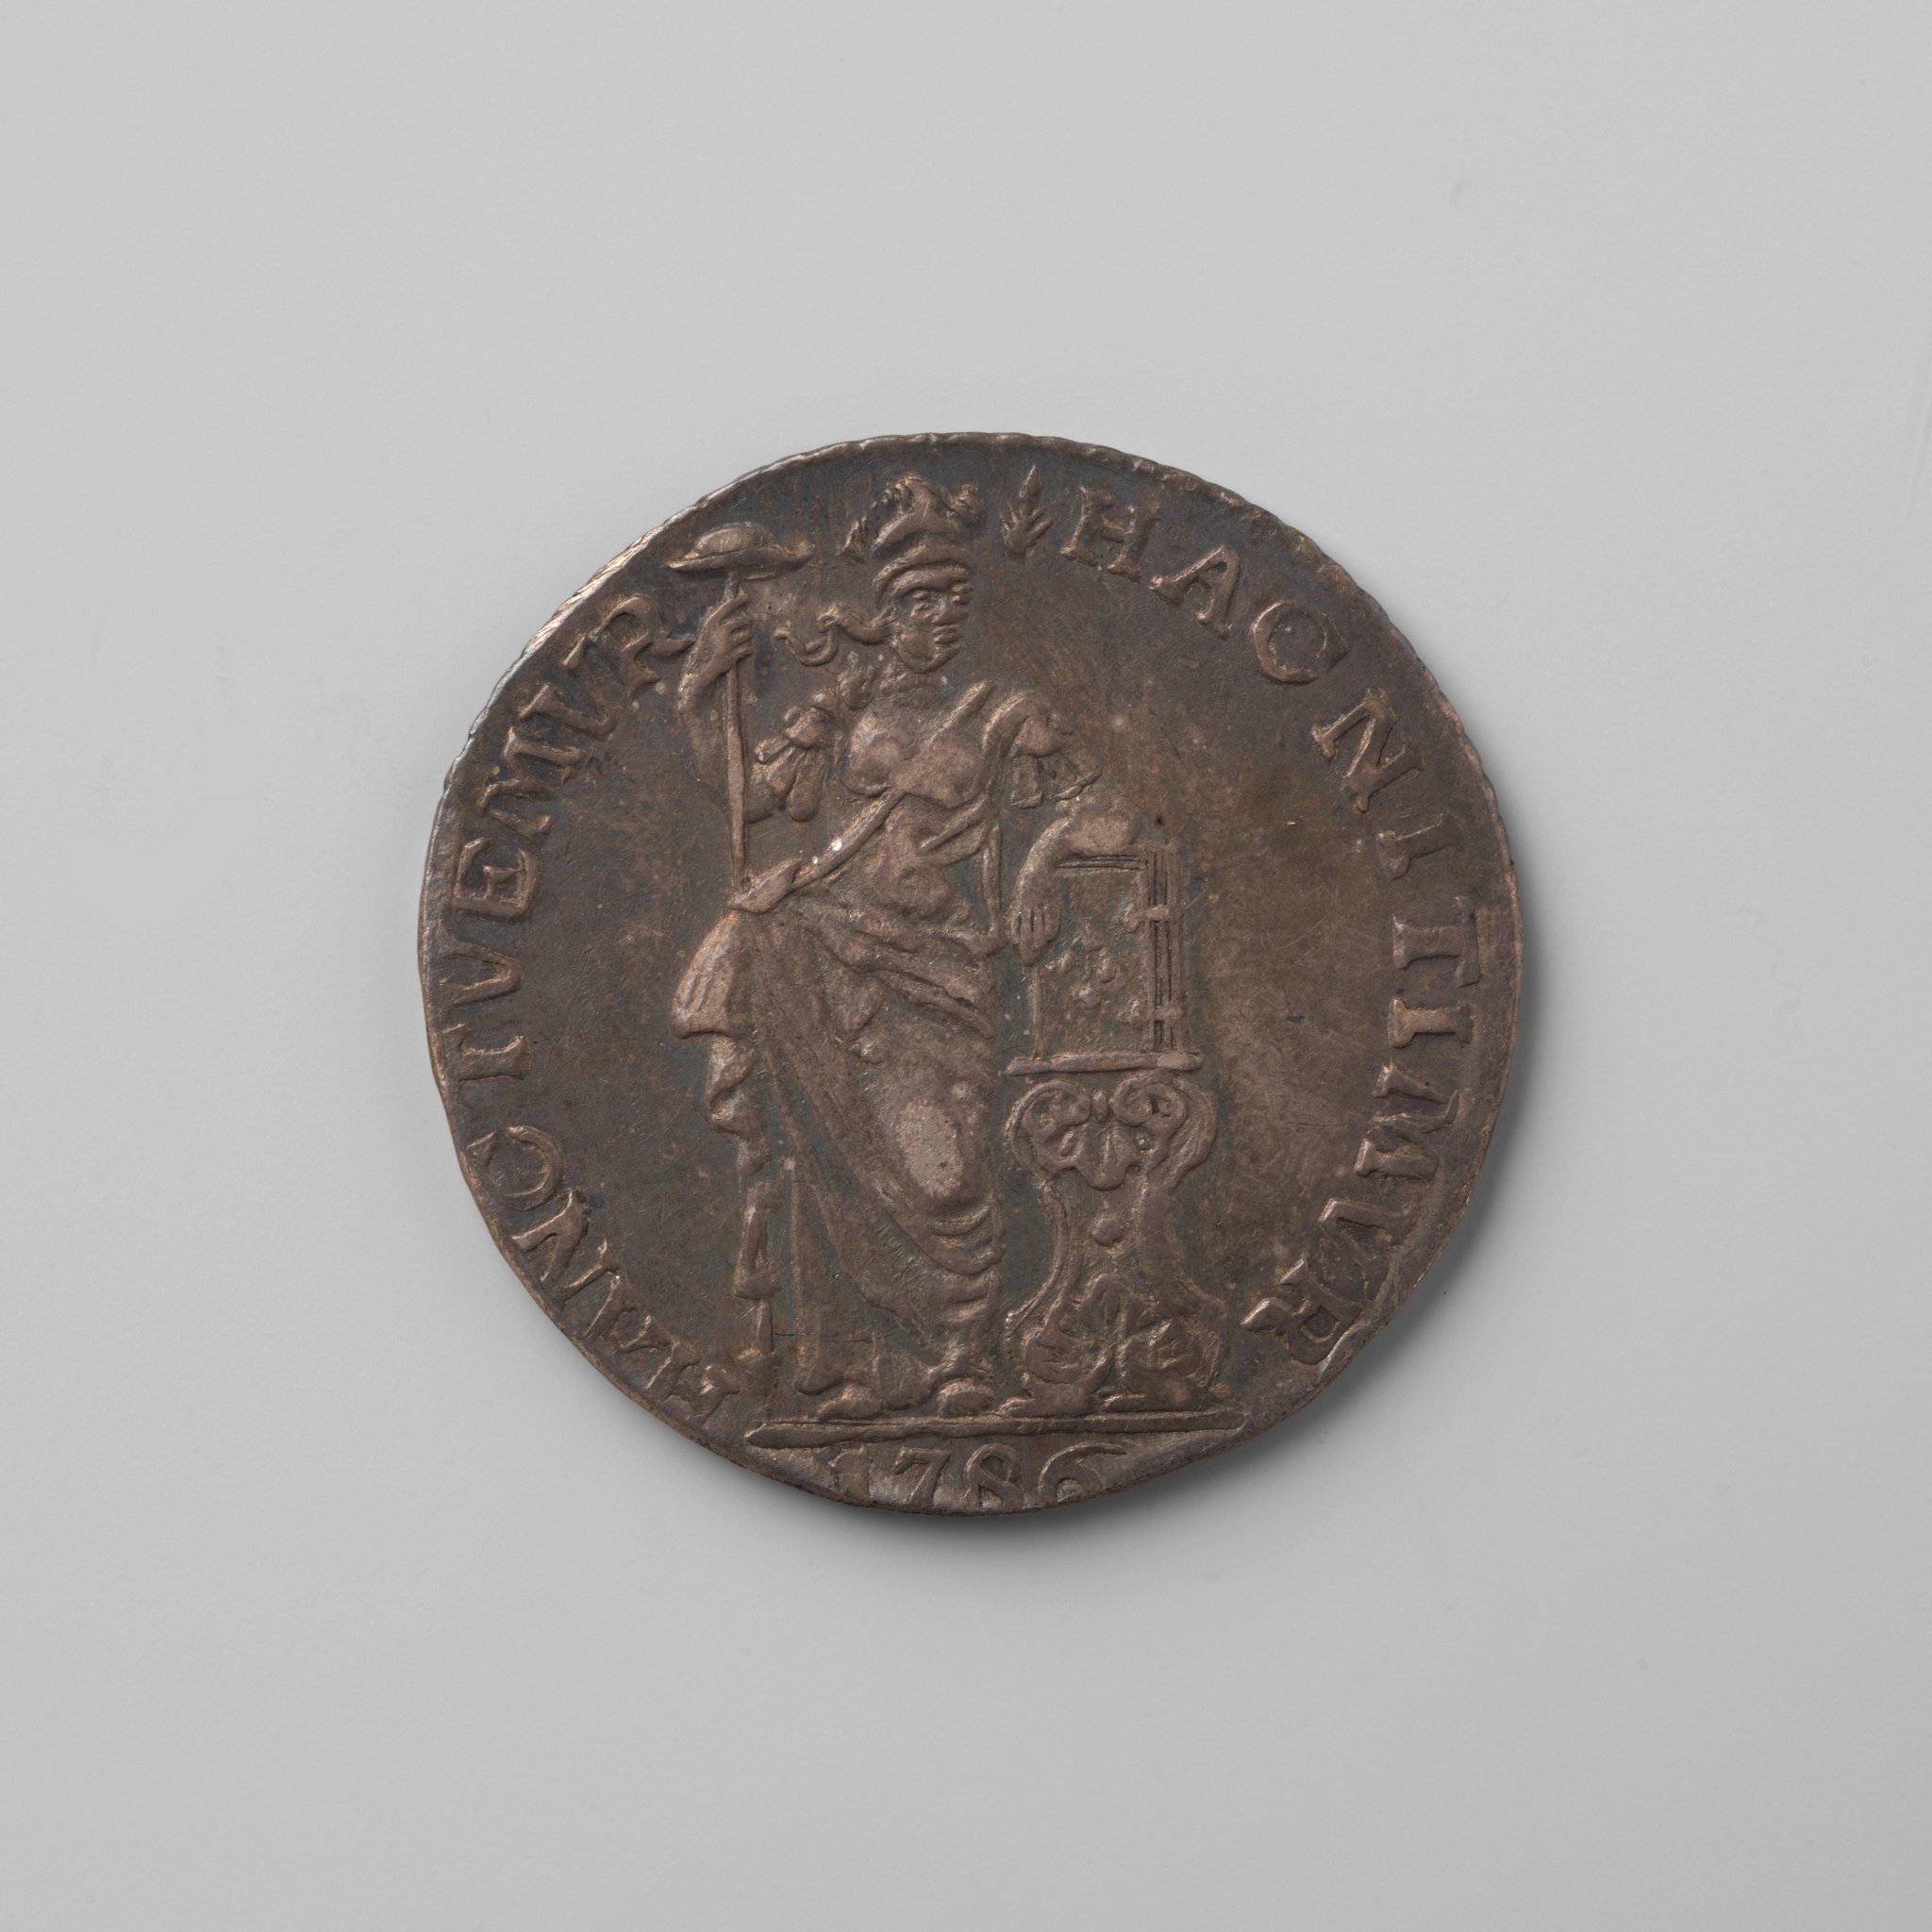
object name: coin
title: VOC, gulden, Gelderland, 1786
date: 1786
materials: silver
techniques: striking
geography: harderwijk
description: Zilveren munt. Voorzijde: tussen waarde-aanduiding I Gl. gekroond generaliteitswapenschild, waaronder cartouche, waarin monogram van de VOC. Keerzijde: Nederlandse maagd met speer, waarop vrijheidshoed, leunend op een bijbel op een altaar. Jaartal in afsnede. Kabelrand.